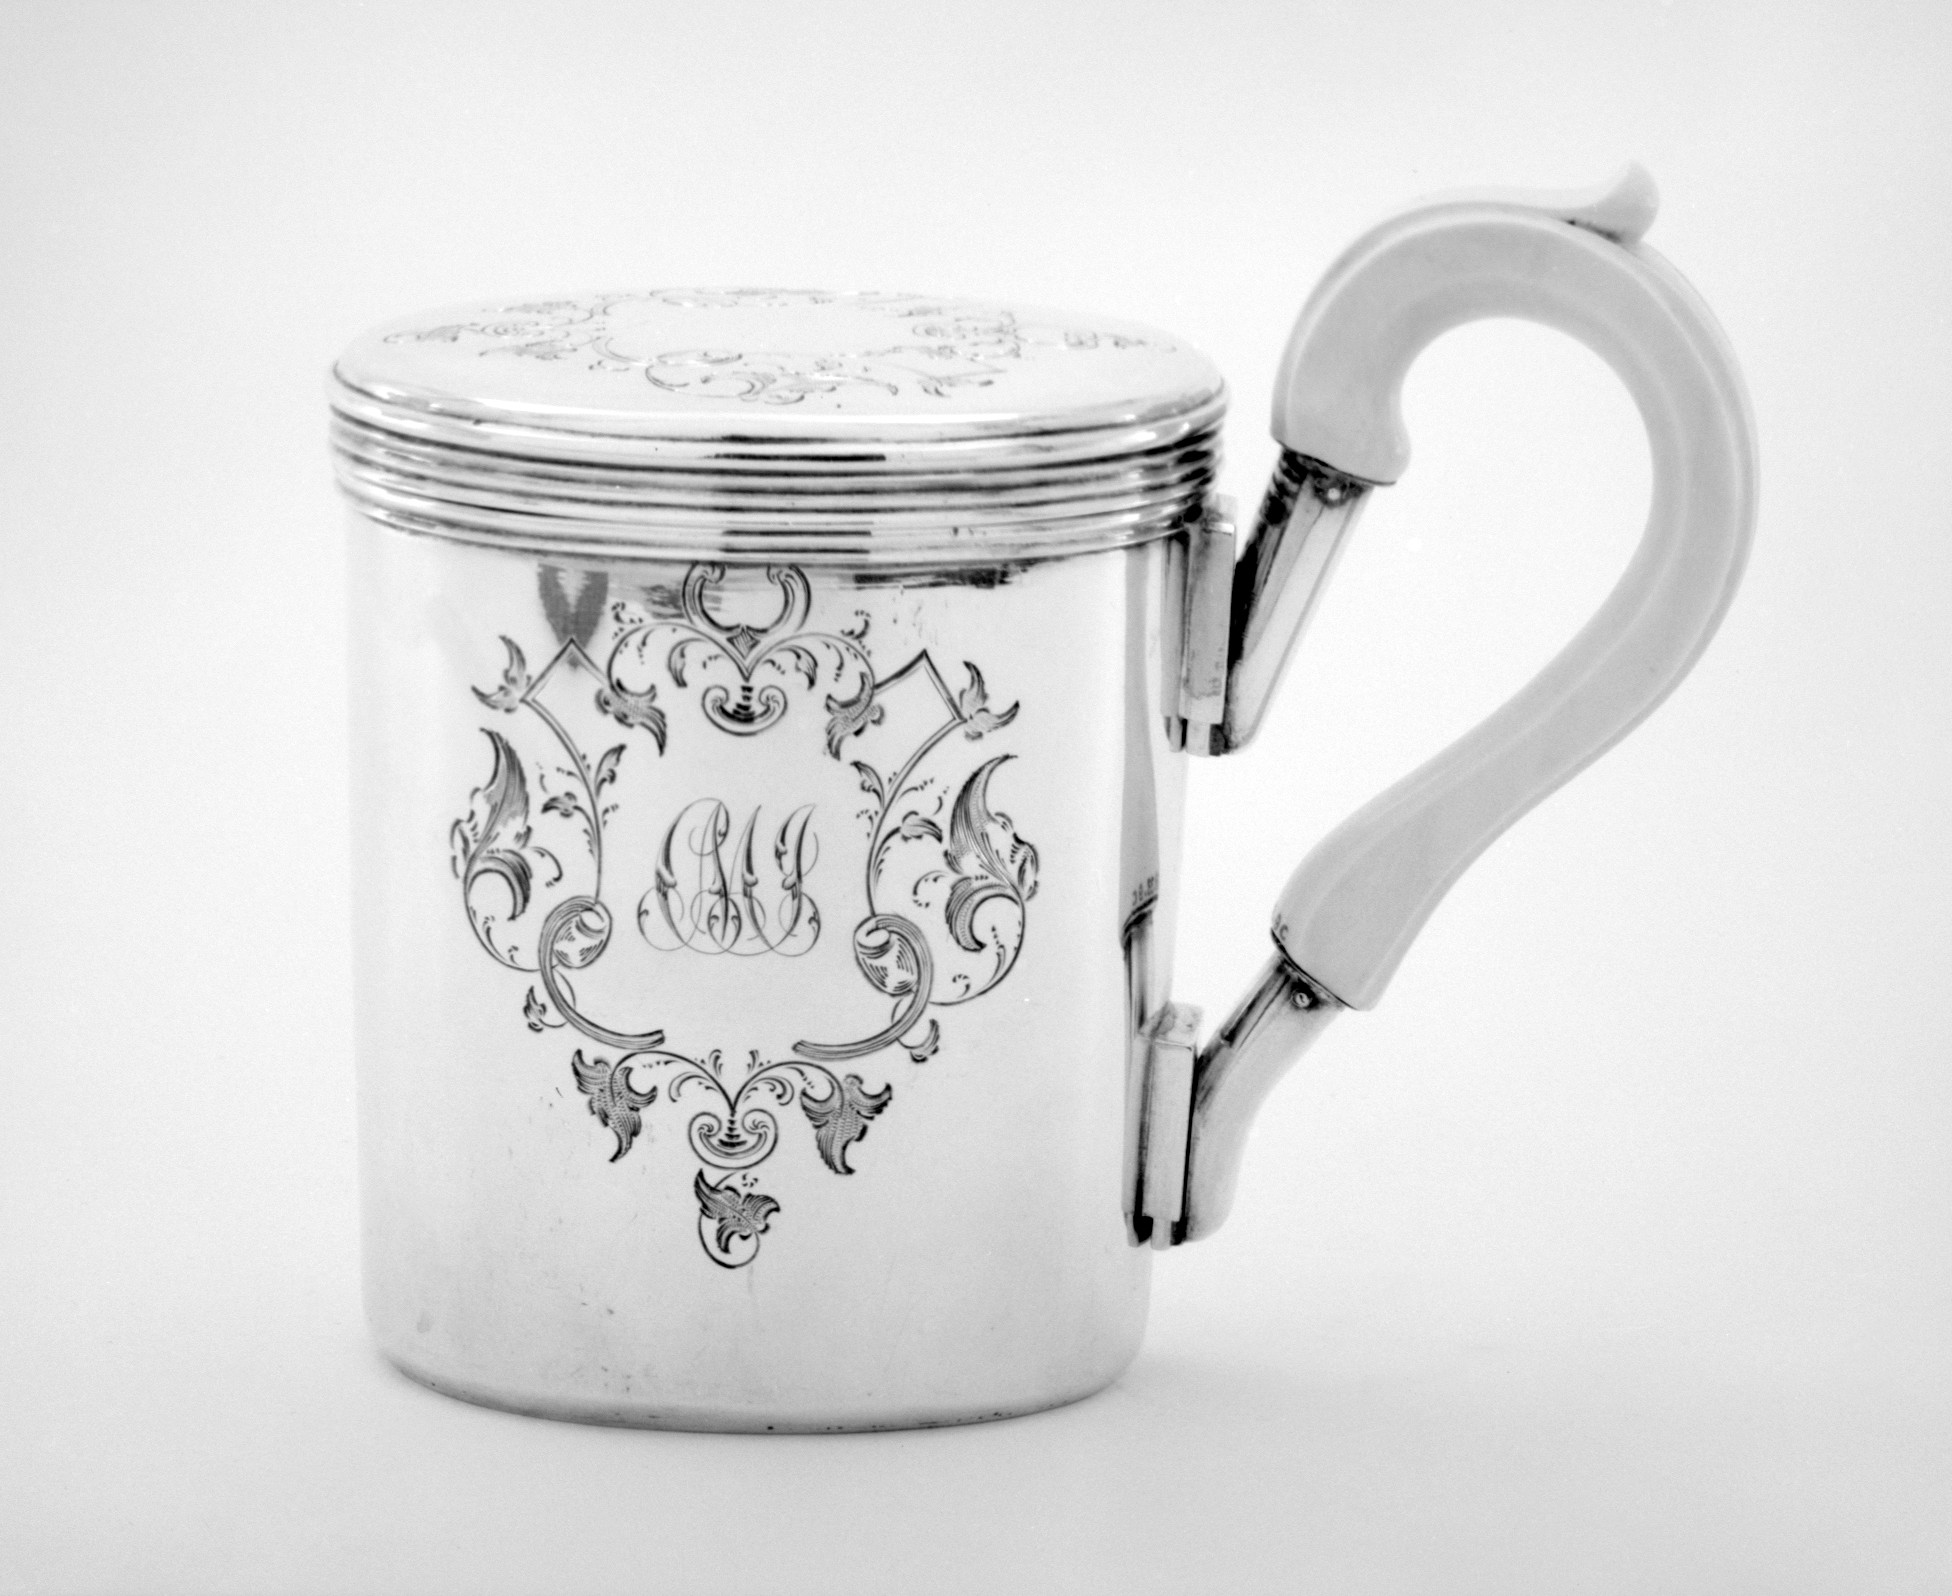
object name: shaving cup with cover and soap dish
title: Shaving cup with cover and handle; soap dish (part of a set)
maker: johann bernhard hertz (hentz)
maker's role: maker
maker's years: 1834-1855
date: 1848-1849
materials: ivory, silver